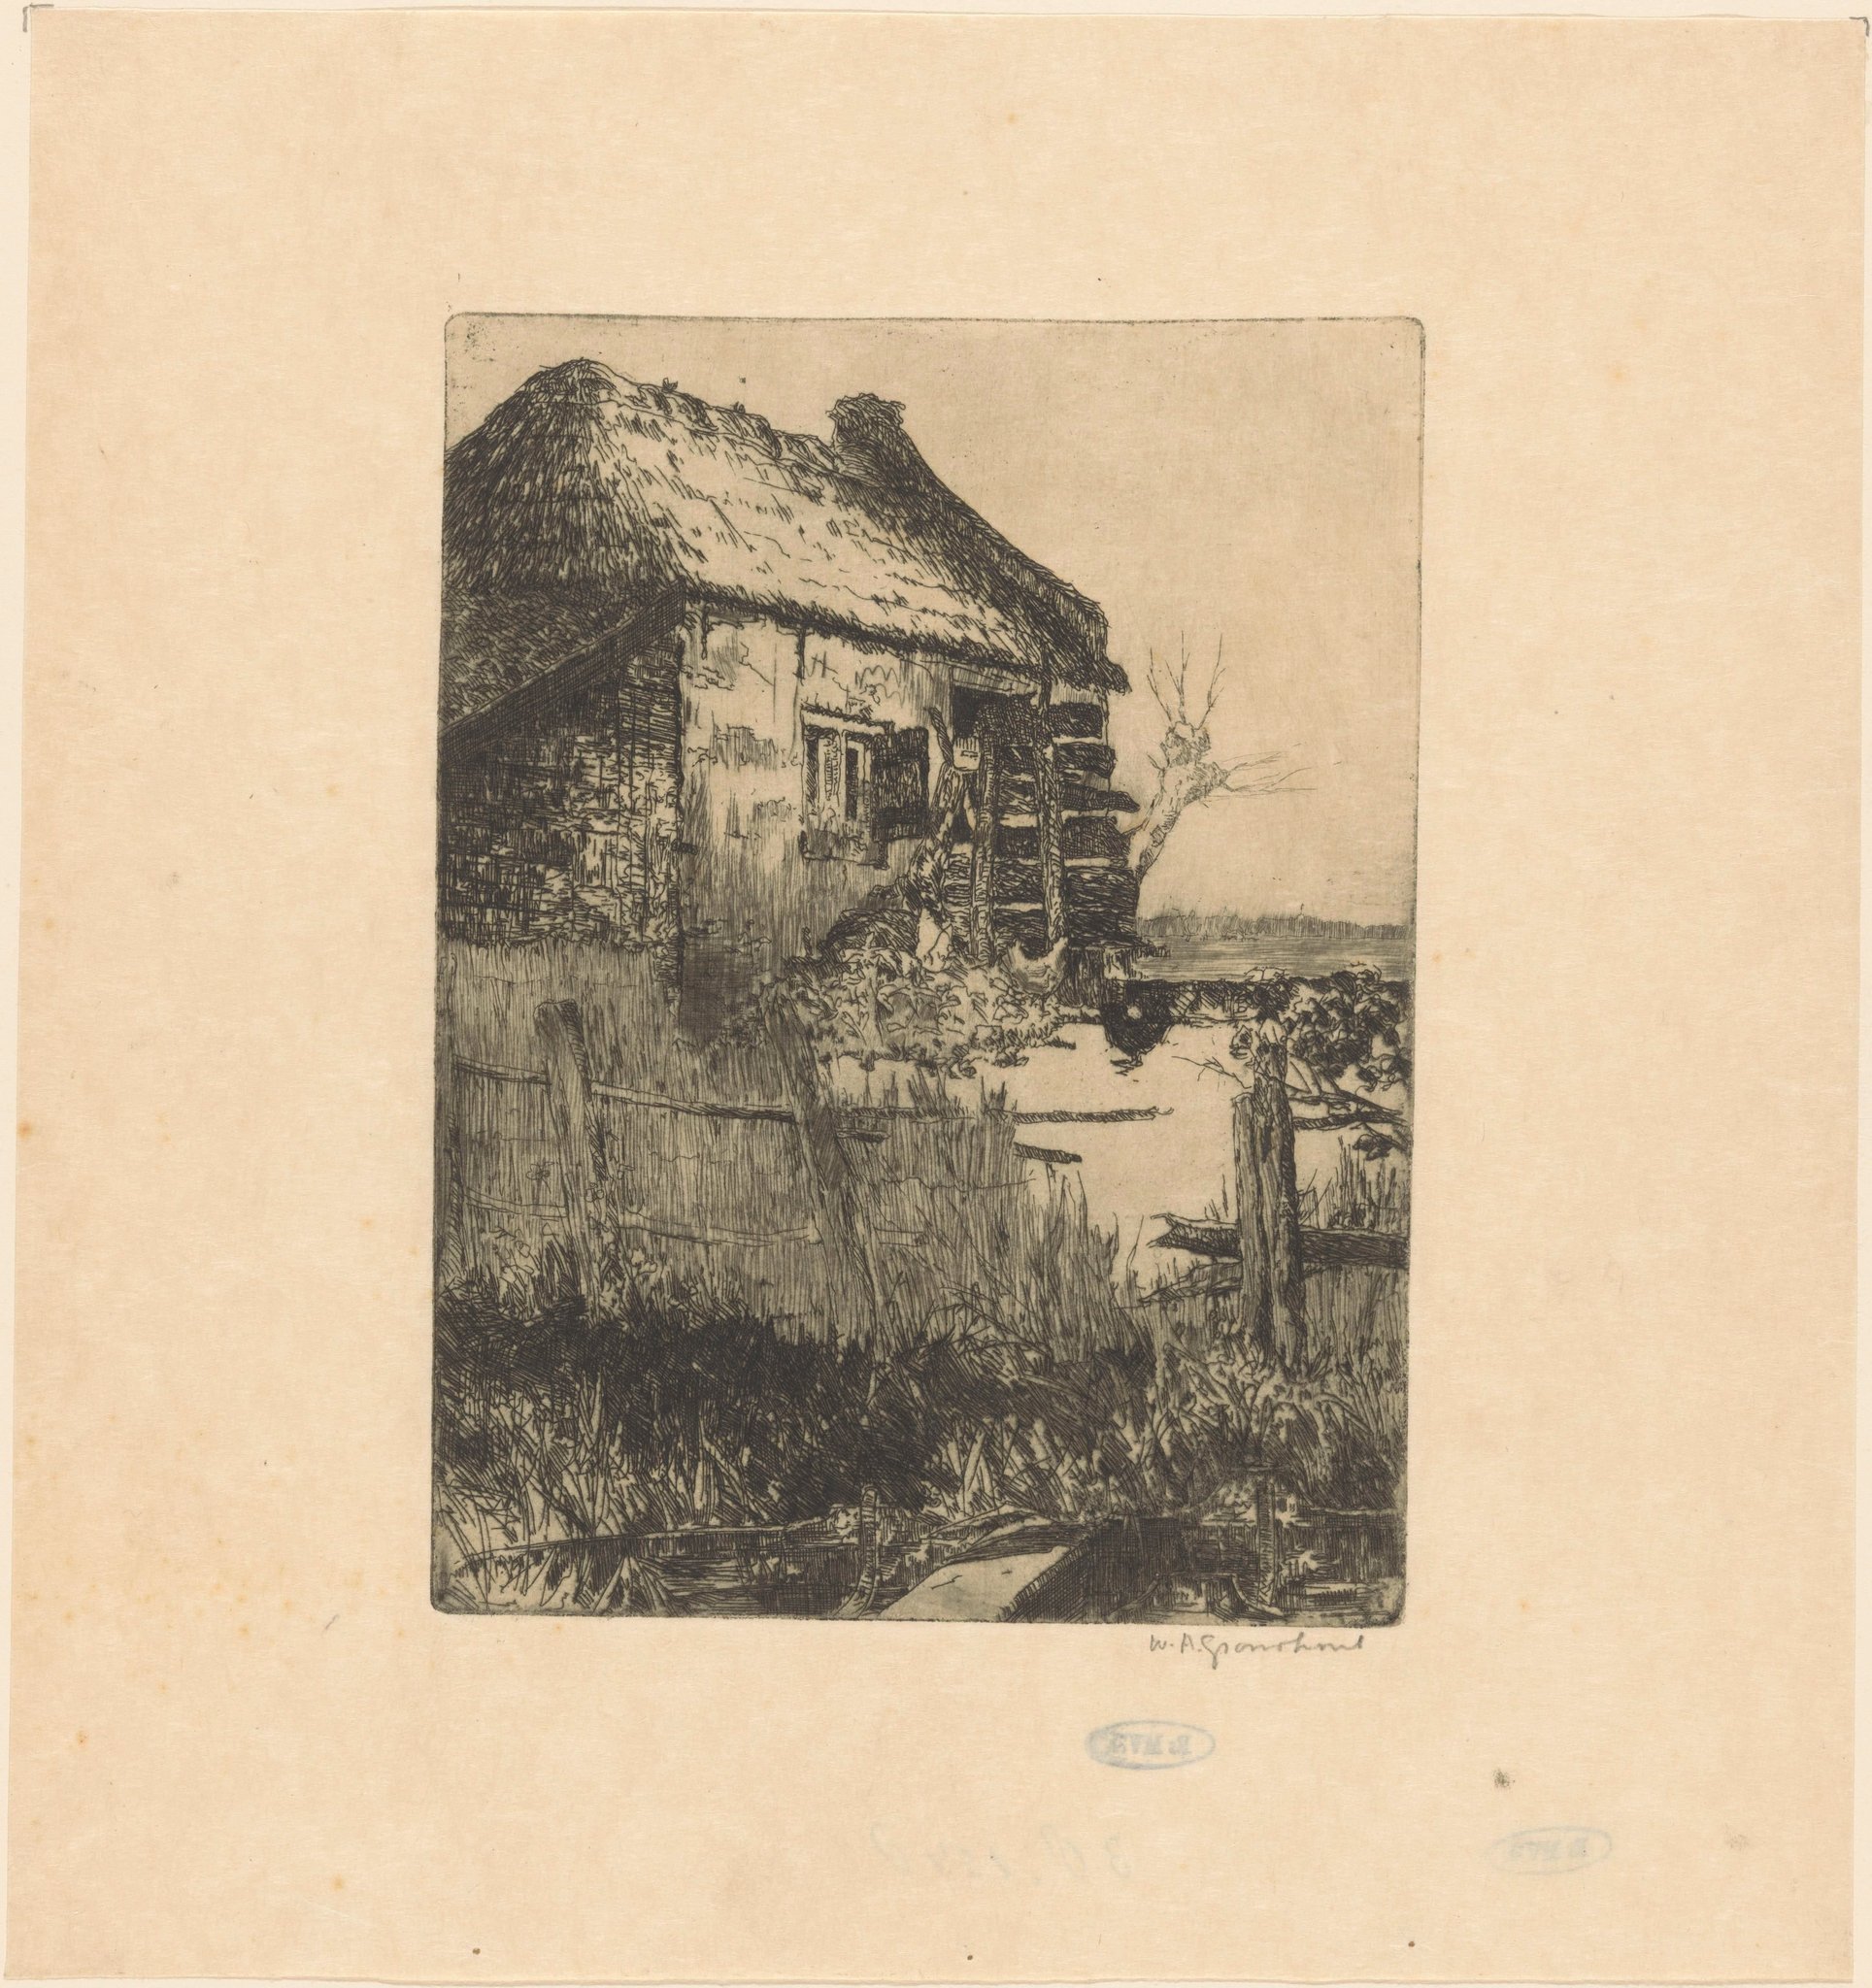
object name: print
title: Schuur in Voorburg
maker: willem adrianus grondhout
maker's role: draughtsman, painter, print maker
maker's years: 1878-1934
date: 1888-1934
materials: paper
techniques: etching, intaglio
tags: barn, voorburg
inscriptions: collector's mark: Lugt 2228